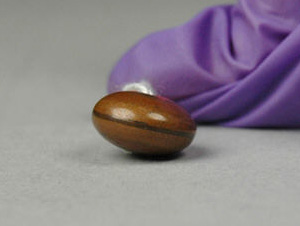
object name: ojime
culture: japanese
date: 1801-1900